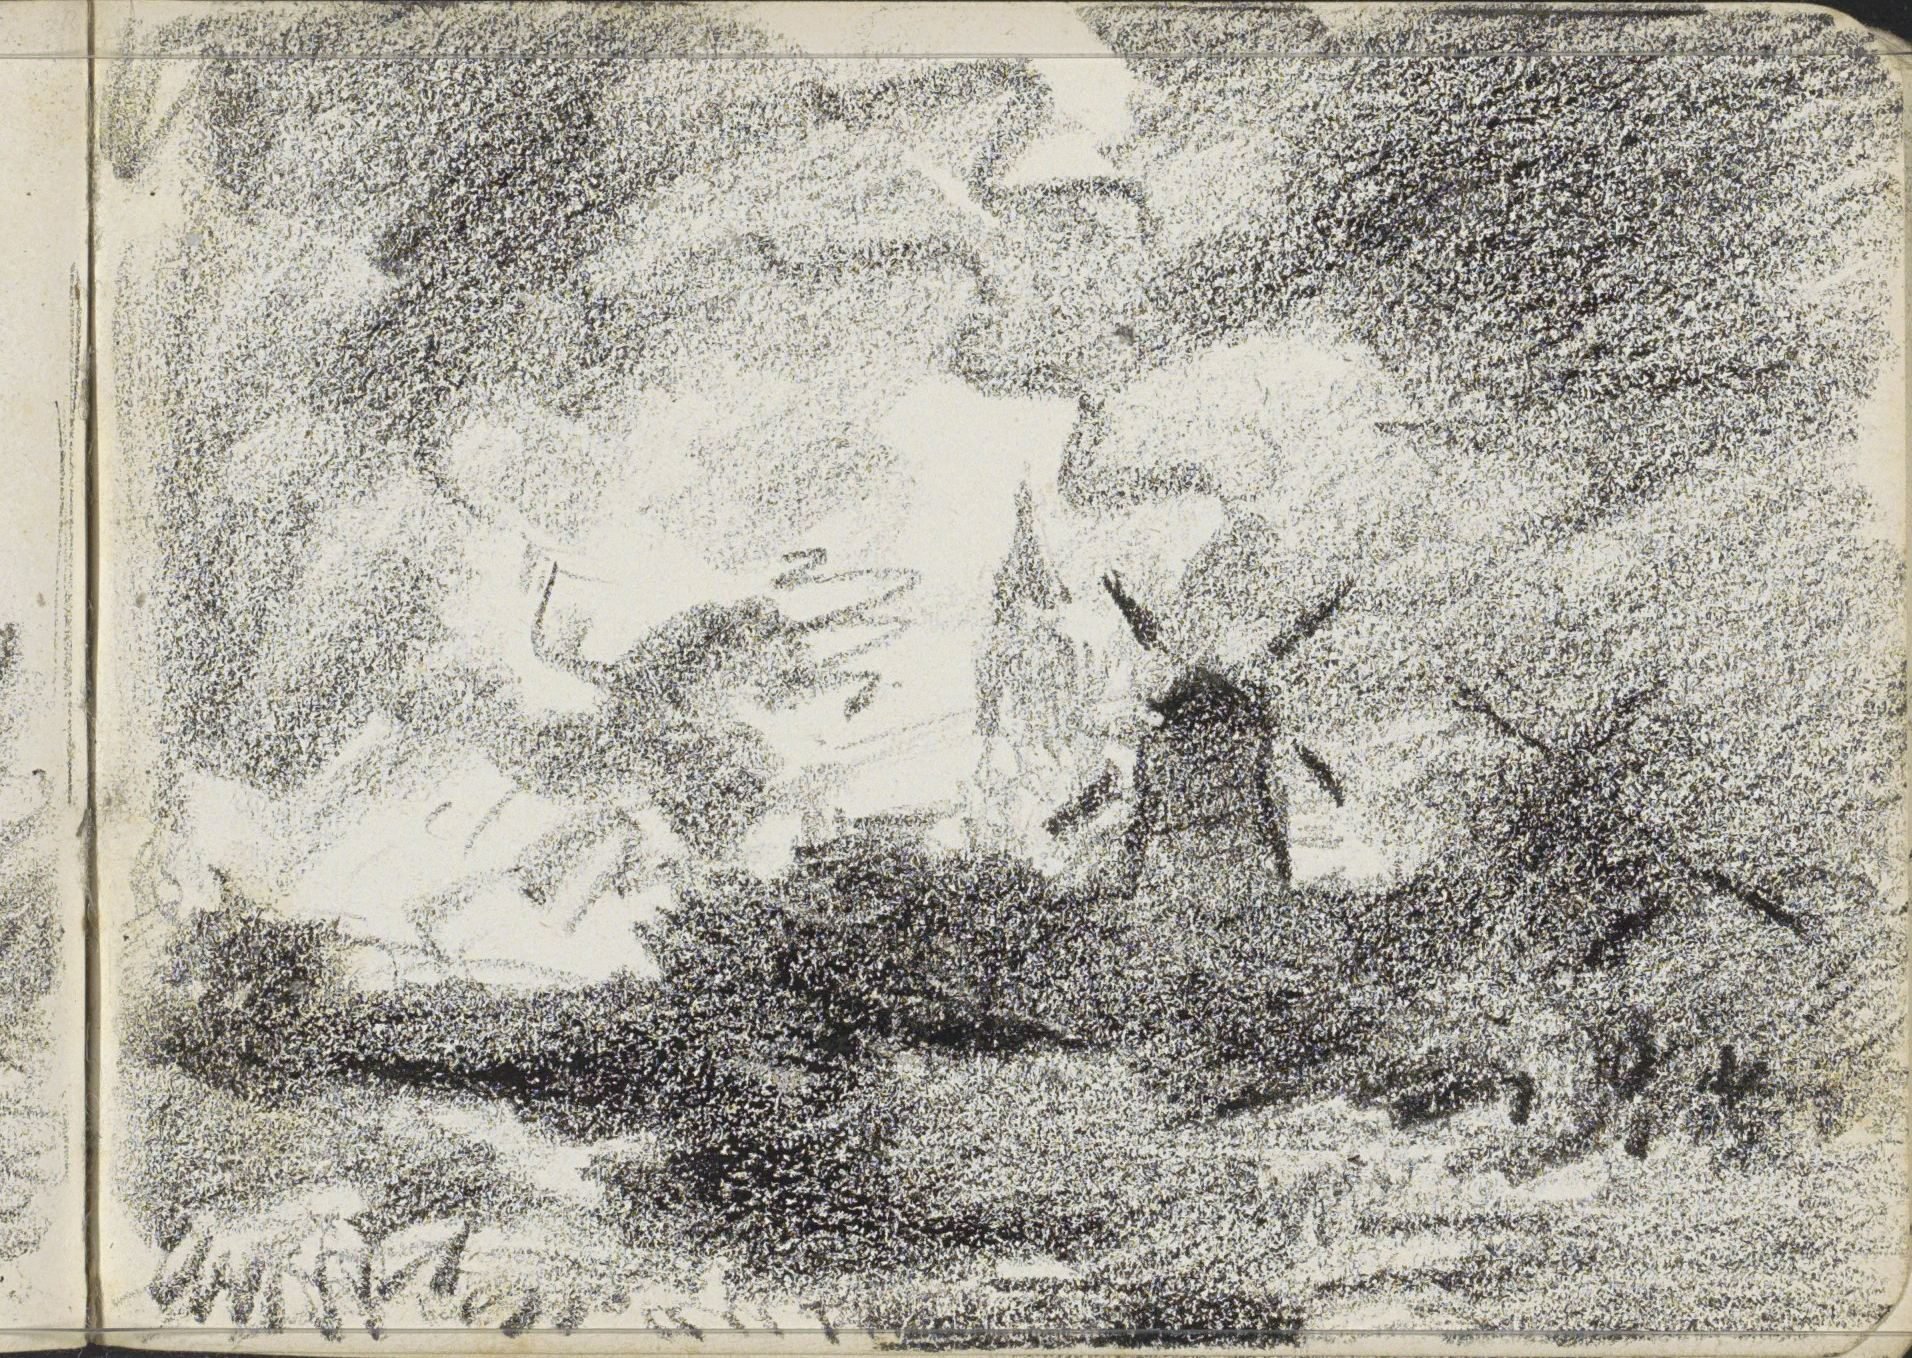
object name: sketchbook leaf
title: Landschap met molens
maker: willem cornelis rip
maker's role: draughtsman, painter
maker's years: 1856-1922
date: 1907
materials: chalk, paper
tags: windmill in landscape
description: Blad 31 recto uit een schetsboek met 41 bladen.